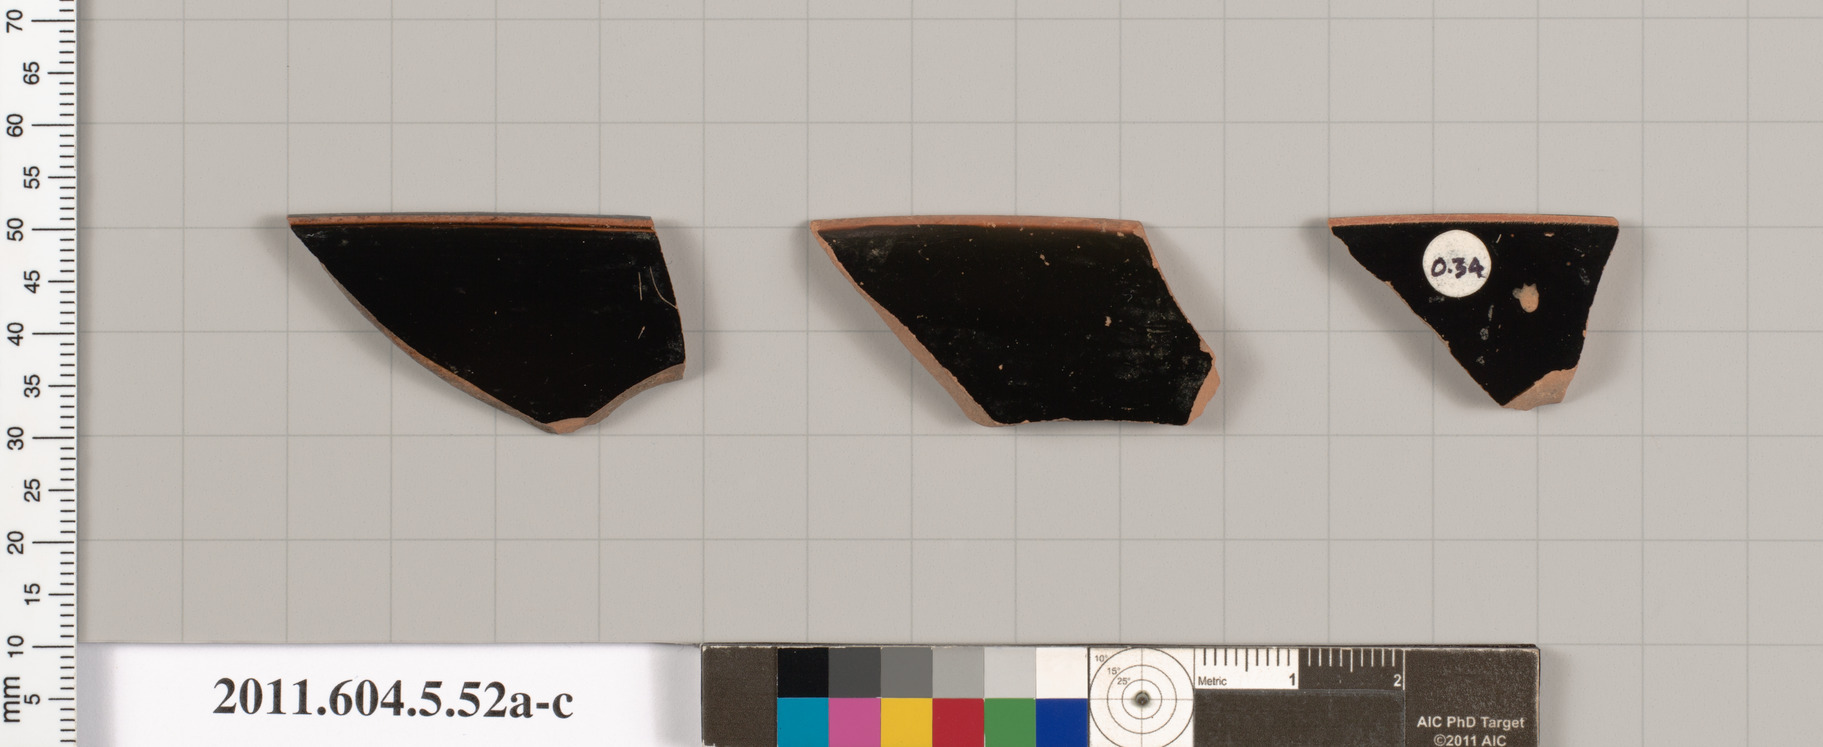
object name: kylix fragment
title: Terracotta rim fragments of kylikes (drinking cups)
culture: greek, attic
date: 500-401 BCE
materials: terracotta